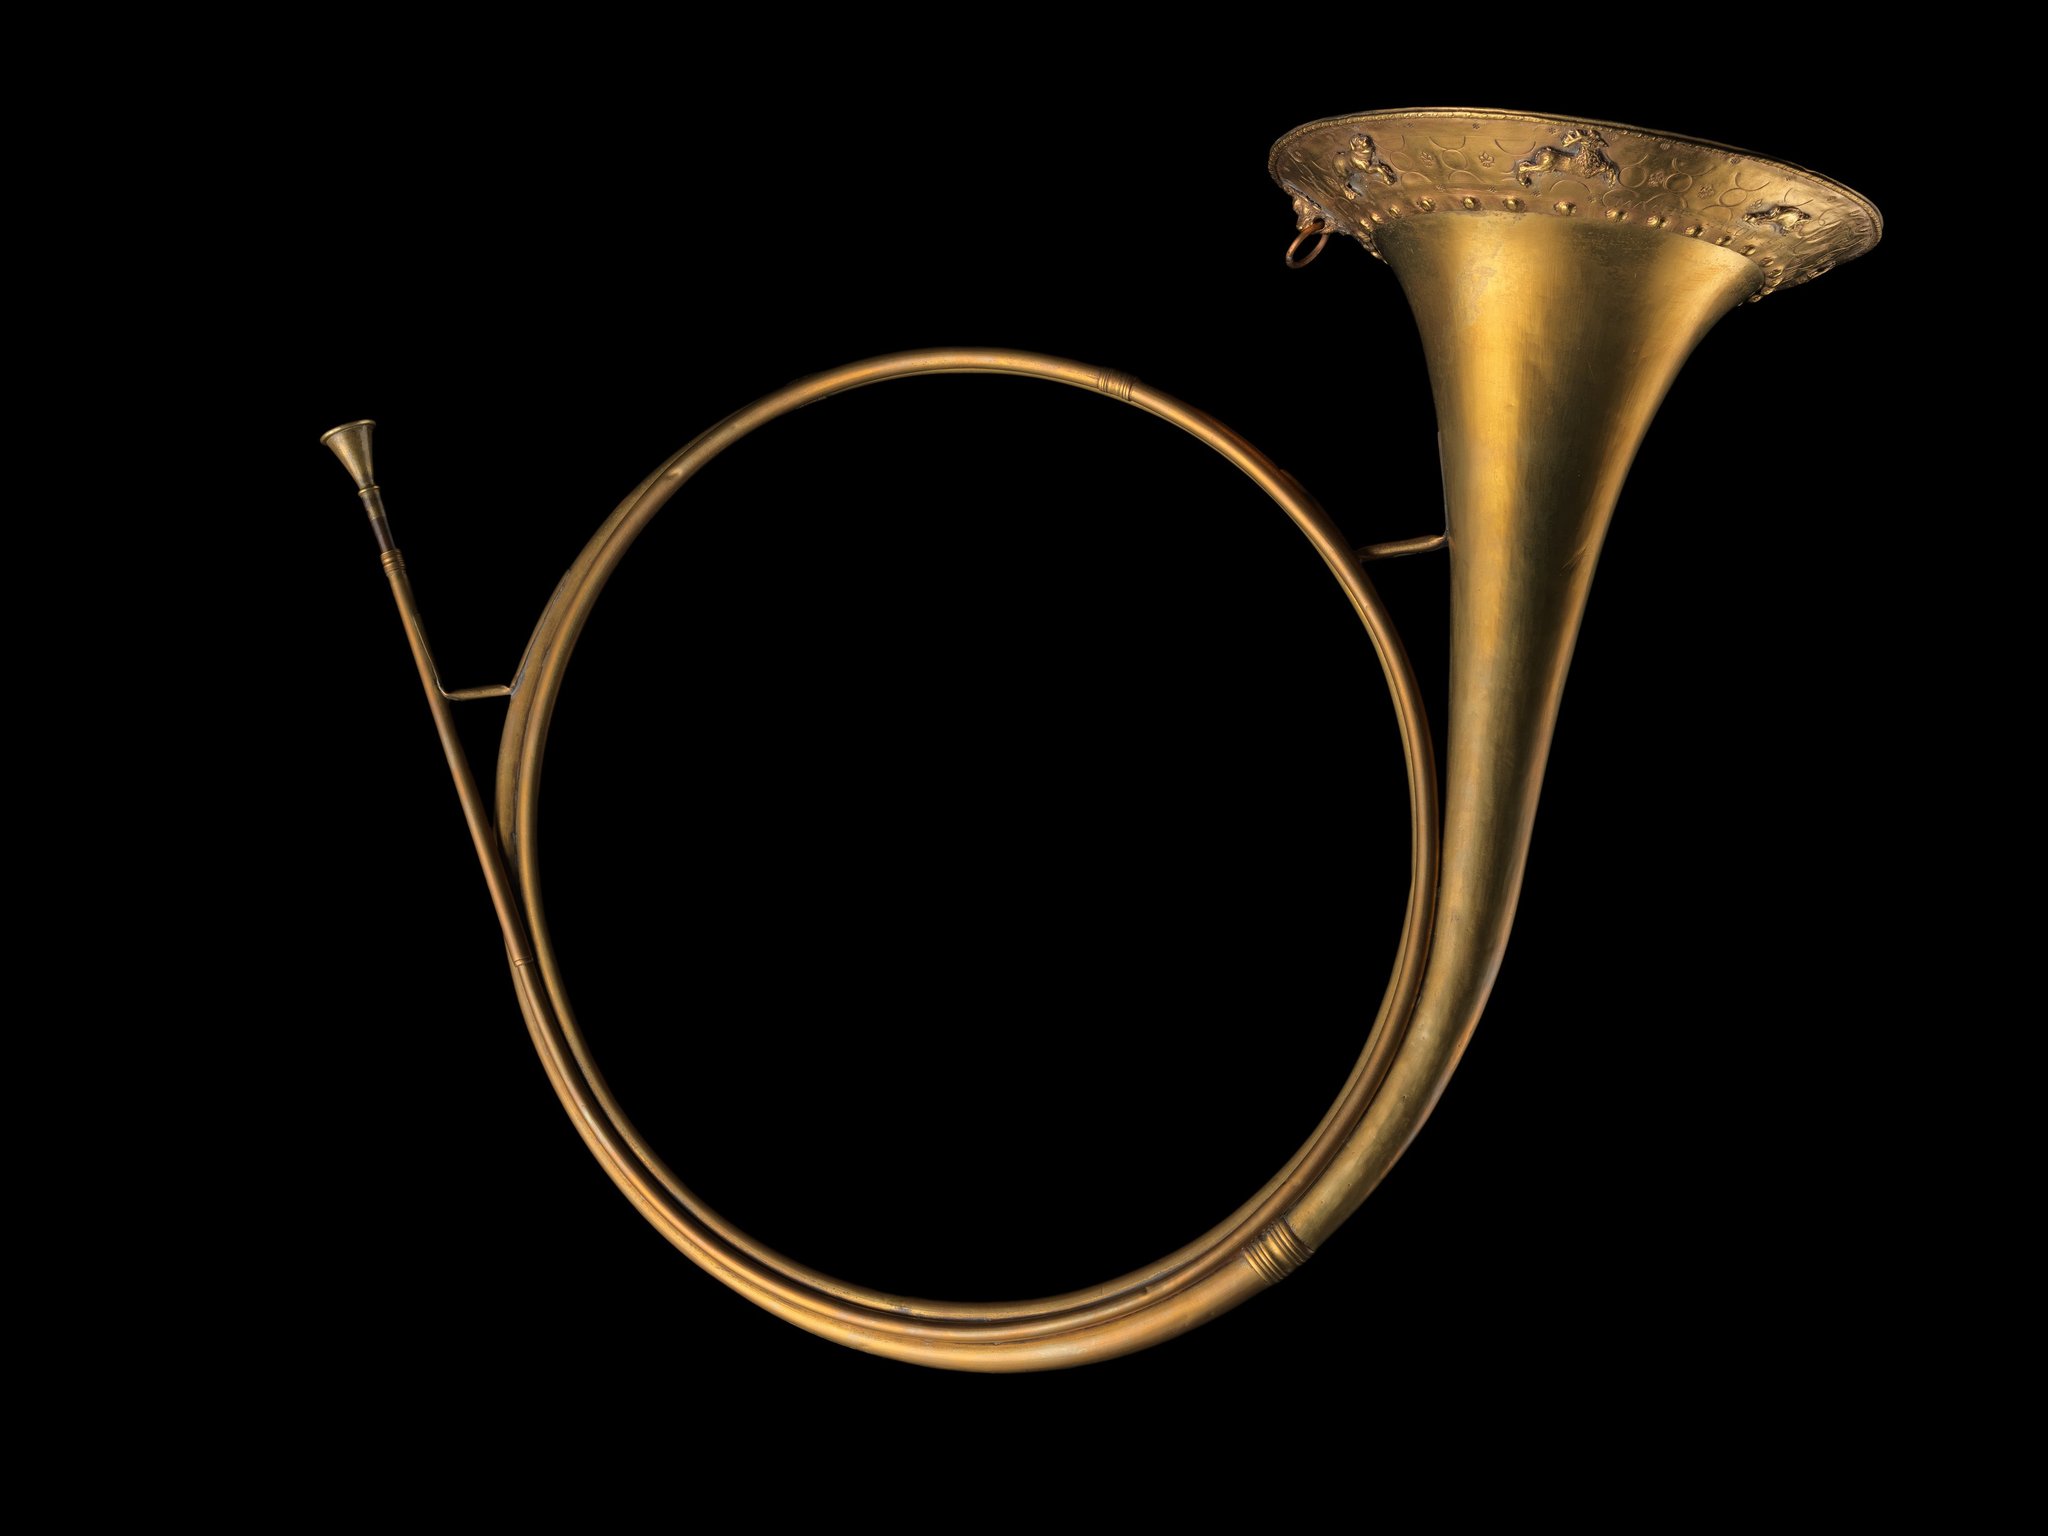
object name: jagdhorn in g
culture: german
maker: jacob schmidt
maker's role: maker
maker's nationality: german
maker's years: 1642-1720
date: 1710-1720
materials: brass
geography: germany